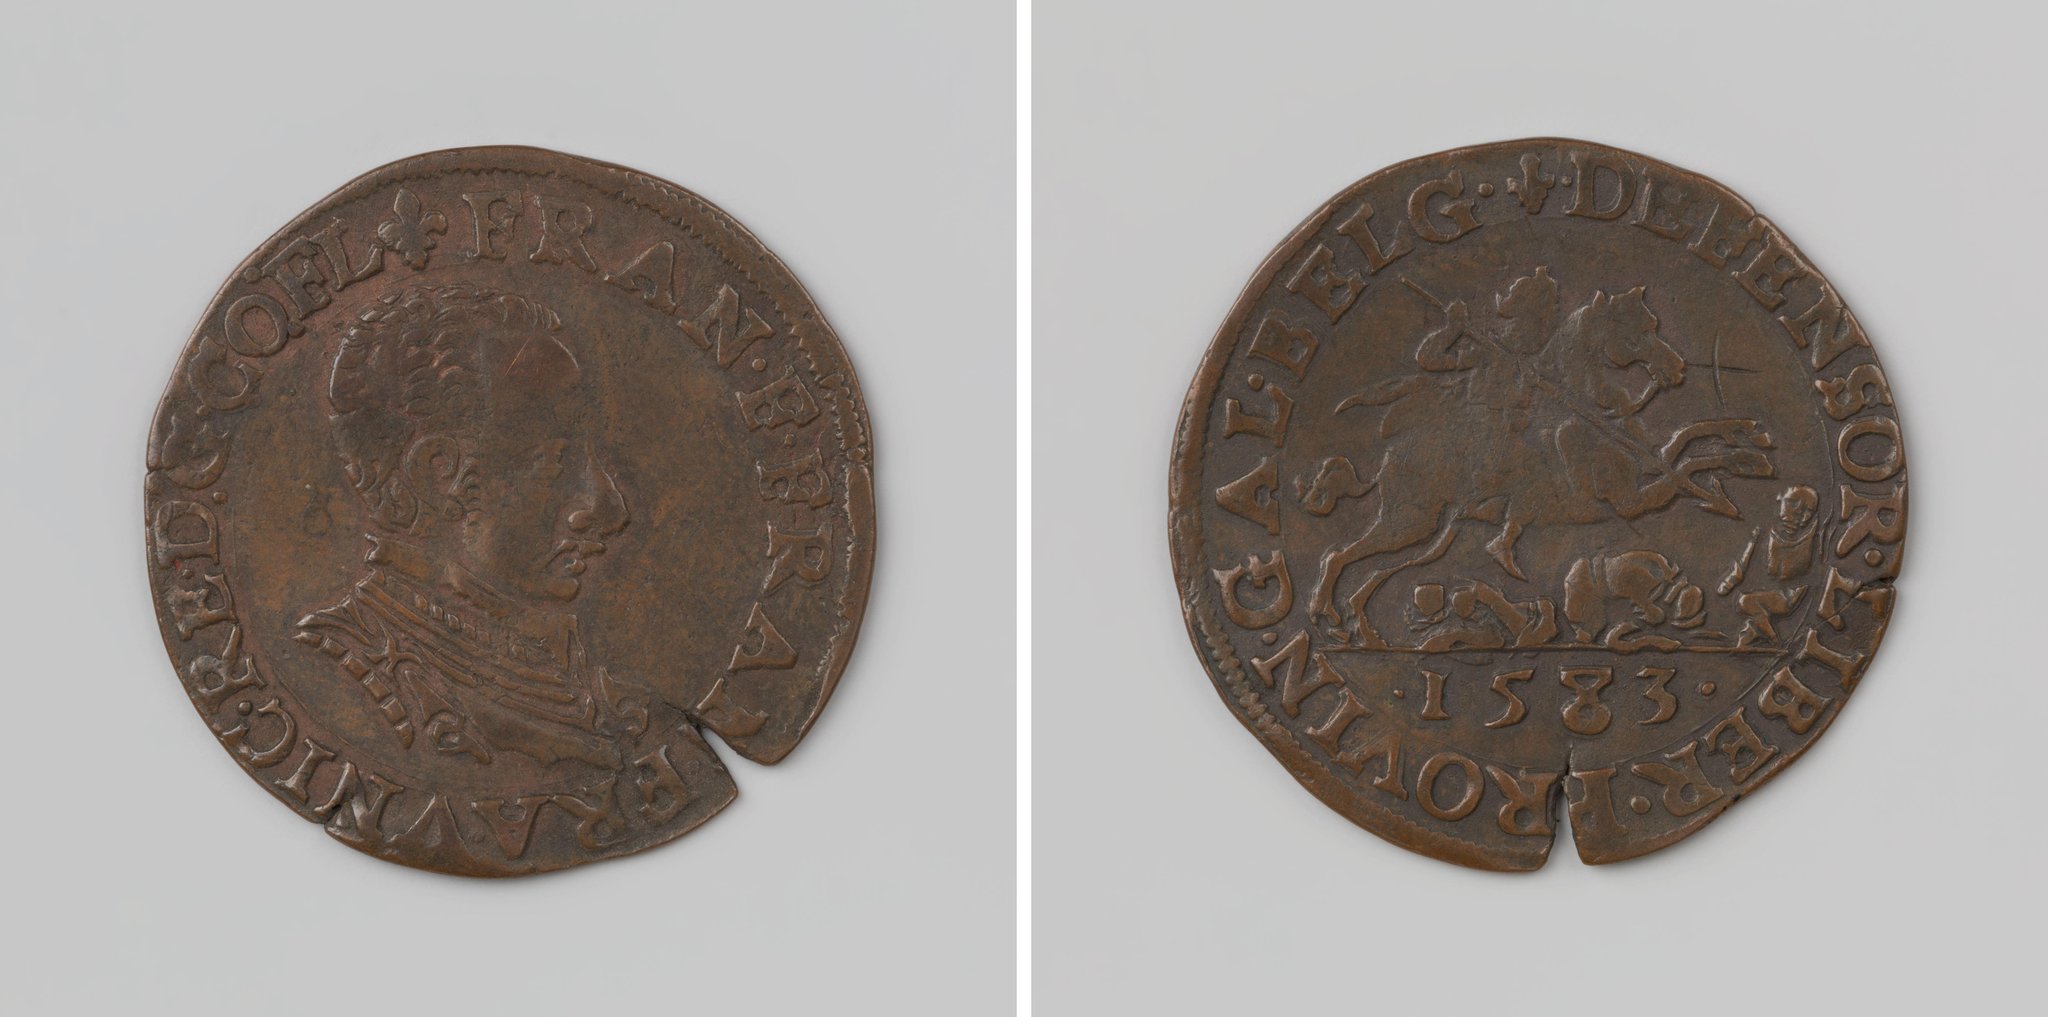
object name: jeton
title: Francois-Hercule, hertog van Anjou, beschermer van Vlaanderen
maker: Anonymous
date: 1583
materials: copper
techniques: striking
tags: paris, françois-hercule de valois (hertog van anjou)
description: Koperen penning. Voorzijde: borststuk man binnen omschrift. Keerzijde: ruiter bestrijdt met lans vijand binnen omschrift; afsnede: jaartal